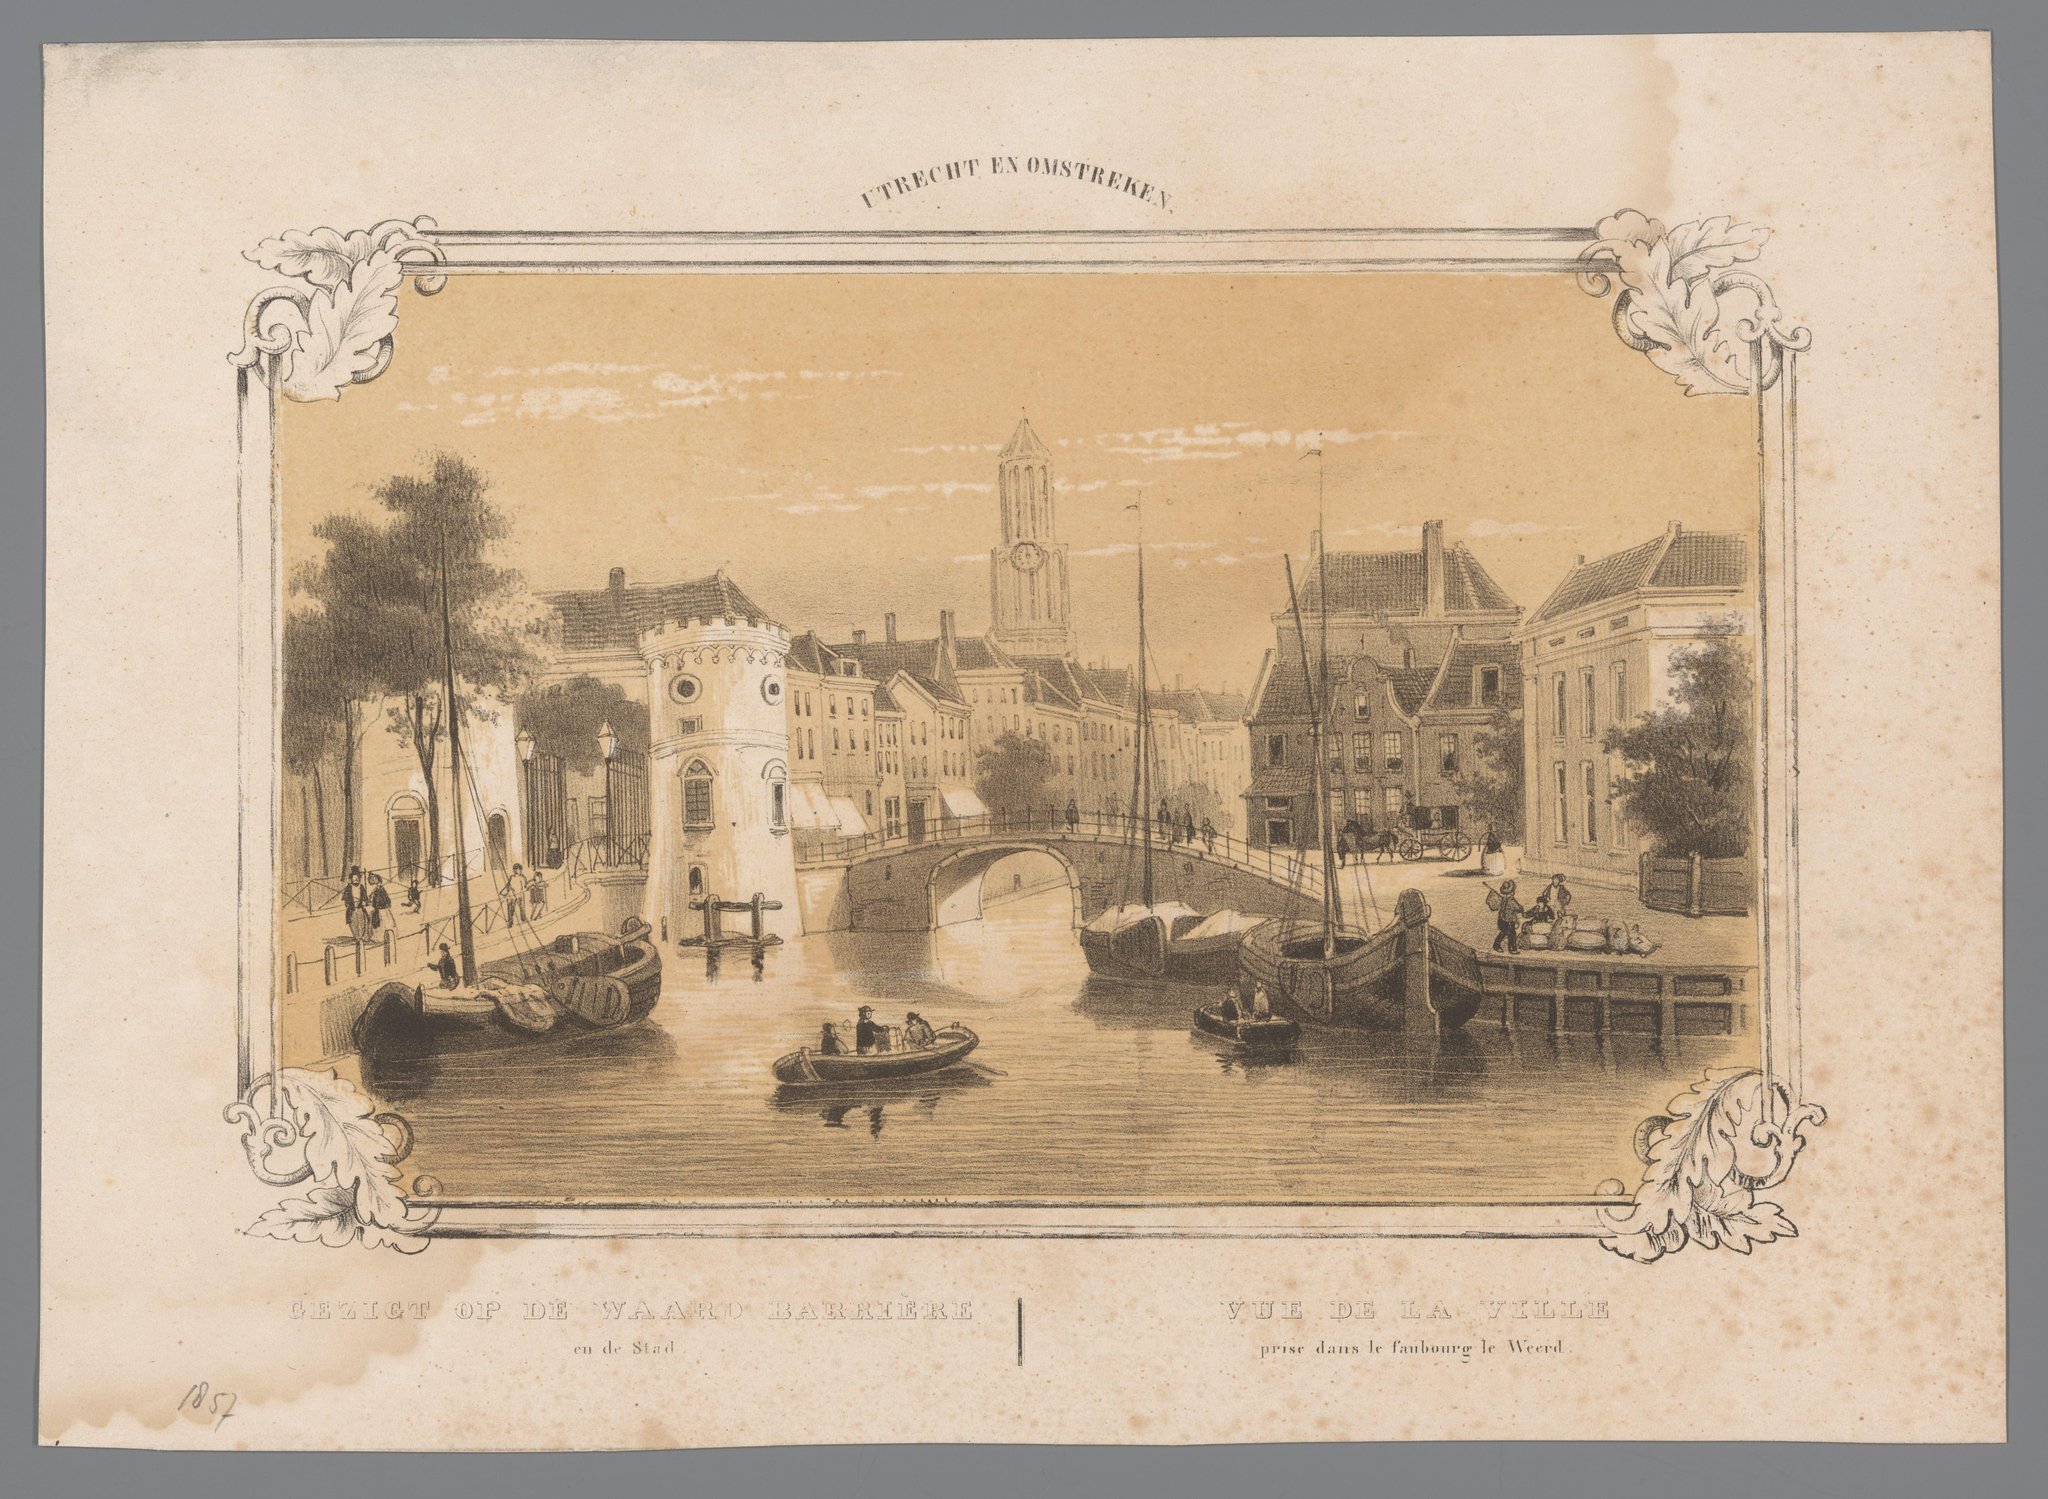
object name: print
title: Gezigt op de Waard Barrière en de Stad / Vue de la Ville prise dans le Faubourg le Weerd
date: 1825-1875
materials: paper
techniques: tone lithography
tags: city-view, and landscape with man-made constructions, canals, waters (in city), utrecht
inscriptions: collector's mark: Lugt 2228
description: gepubliceerd in 'Cahier Gezigten in Utrecht en Omstreken'